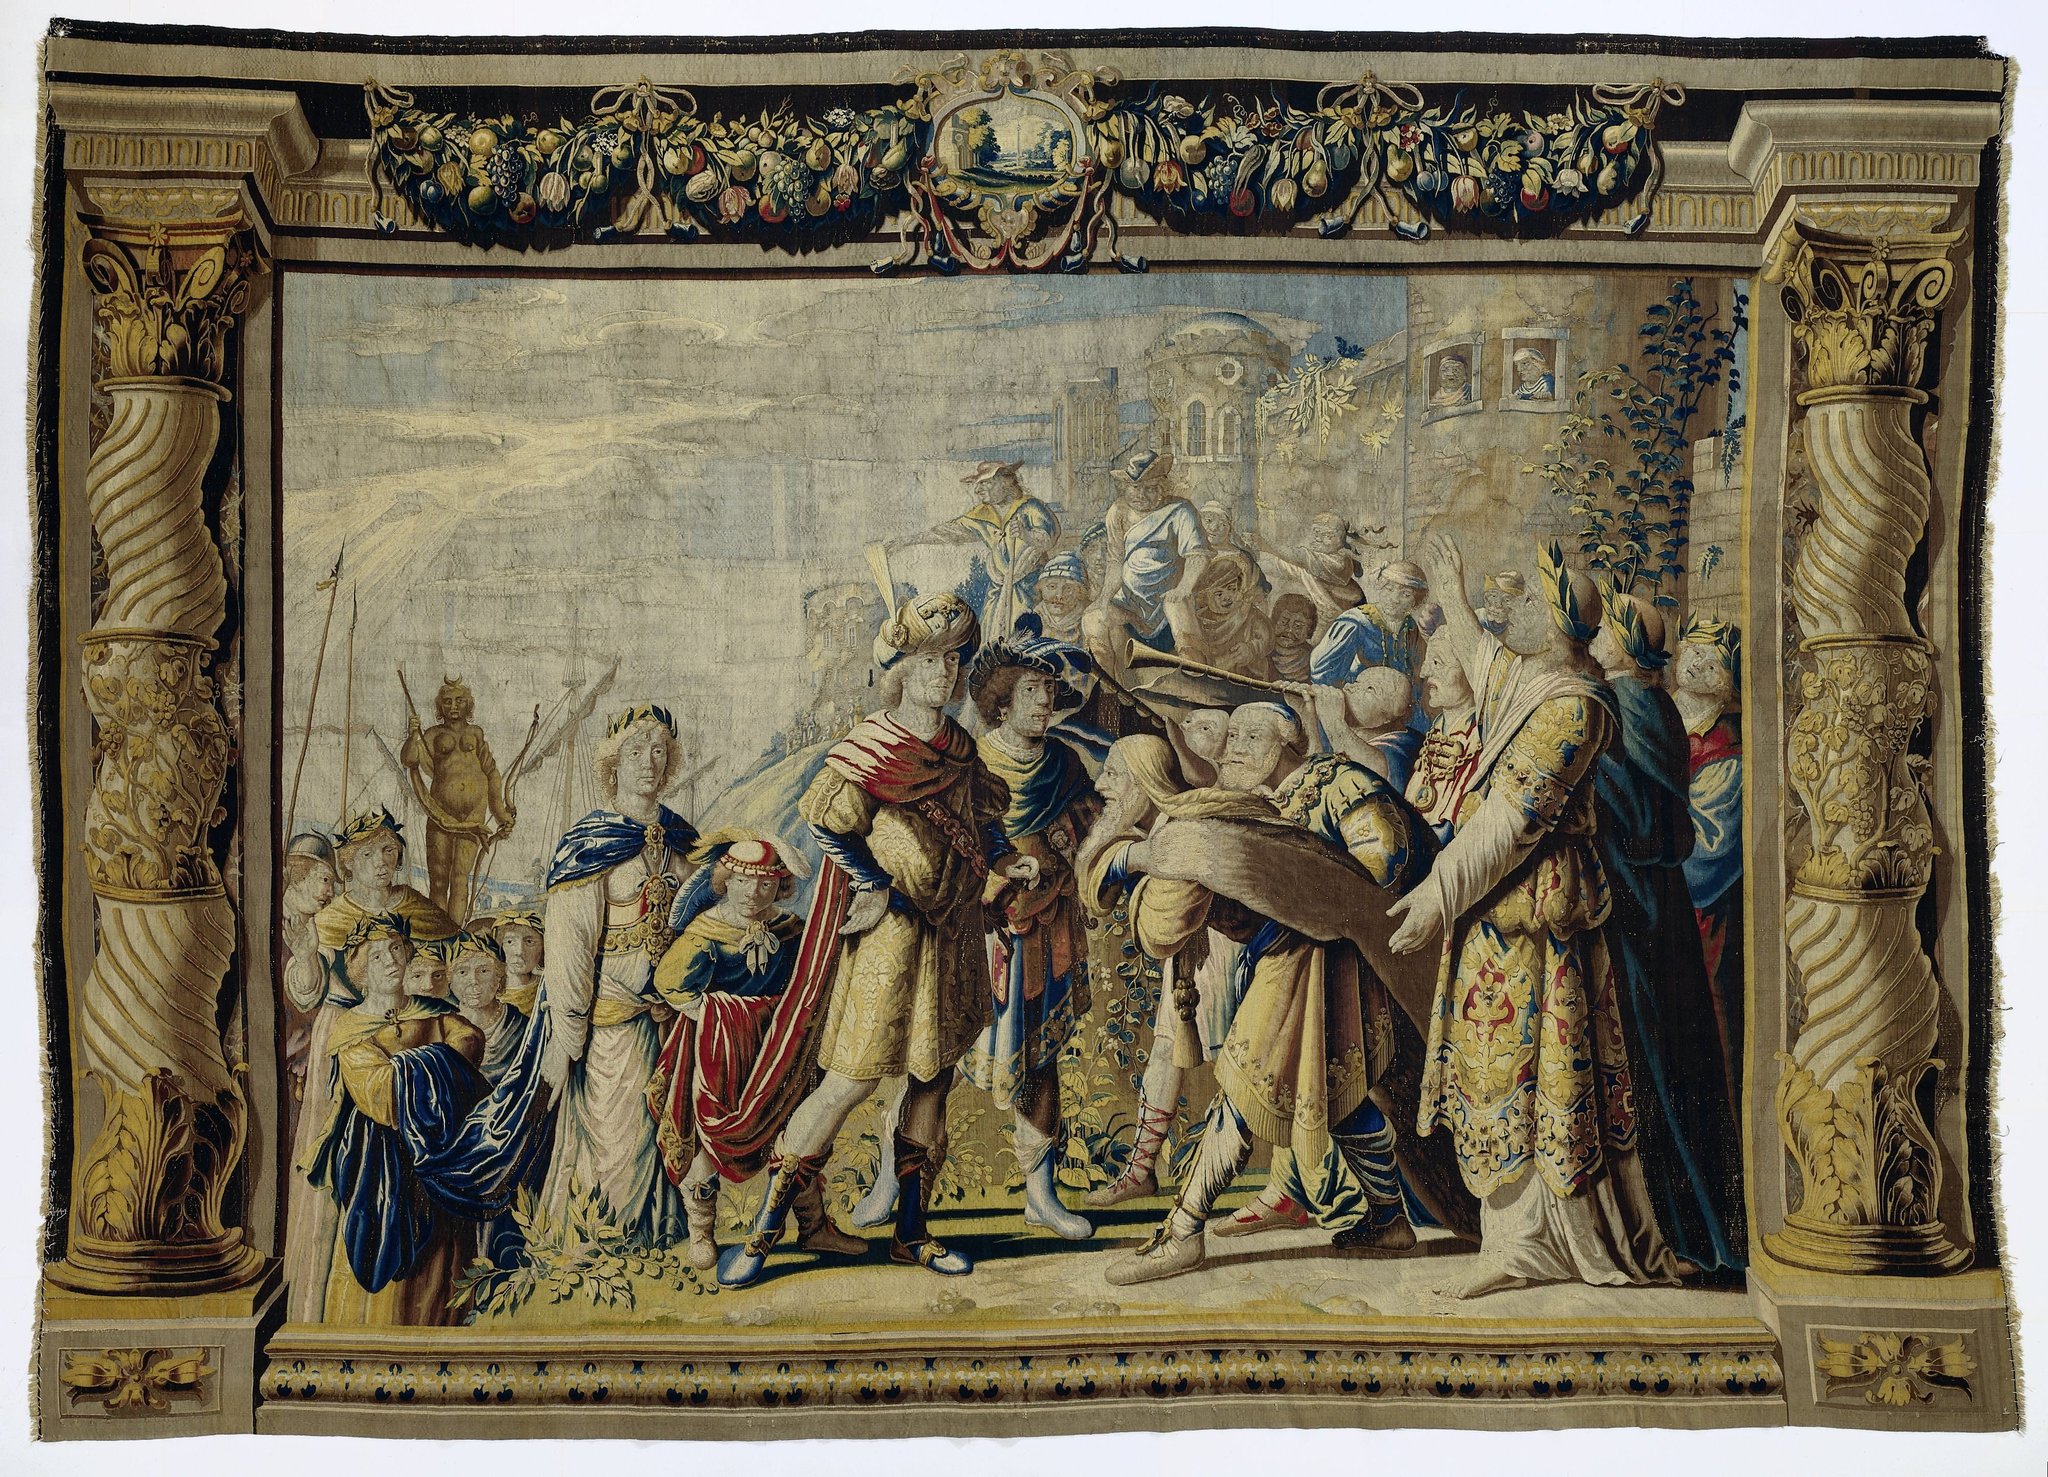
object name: tapestry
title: De thuiskomst van Orestes en Iphigenia in Aulis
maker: salomon de bray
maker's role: draughtsman, print maker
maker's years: 1597-1664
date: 1648-1662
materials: silk, wool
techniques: tapestry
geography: northern netherlands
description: Wandtapijt met thuiskomst in Aulis van Orestes en Iphigeneia, die het beeld van Artemis met zich voren. Rechts het hoge strand bebouwd met torens en vestingwerken, waarvoor de inwoners juichend zijn uitgelopen. Op de voorgrond met lauwerkransen getooide priesters (?) en ..... van het land die Orestes en Pylades buigend verwelkomen. De helden zijn getooid met gepluimde tulband en ingesneden baret, over de schouder hangt een sleep die door een page wordt gedragen. Hierna volgt Iphygeneia met lauwerkrans en blauwe sleep, gedragen door een dienares; haar gevolg staat op een lager deel van het strand. Achteraan is het beeld van Artemis met maansikkel en pijl en boog. In het verschiet zijn de toppen van de scheepsmasten zichtbaar. Ook hier een sterk van links invallend licht, contrasterend met diepe schaduwen. Rand als A.